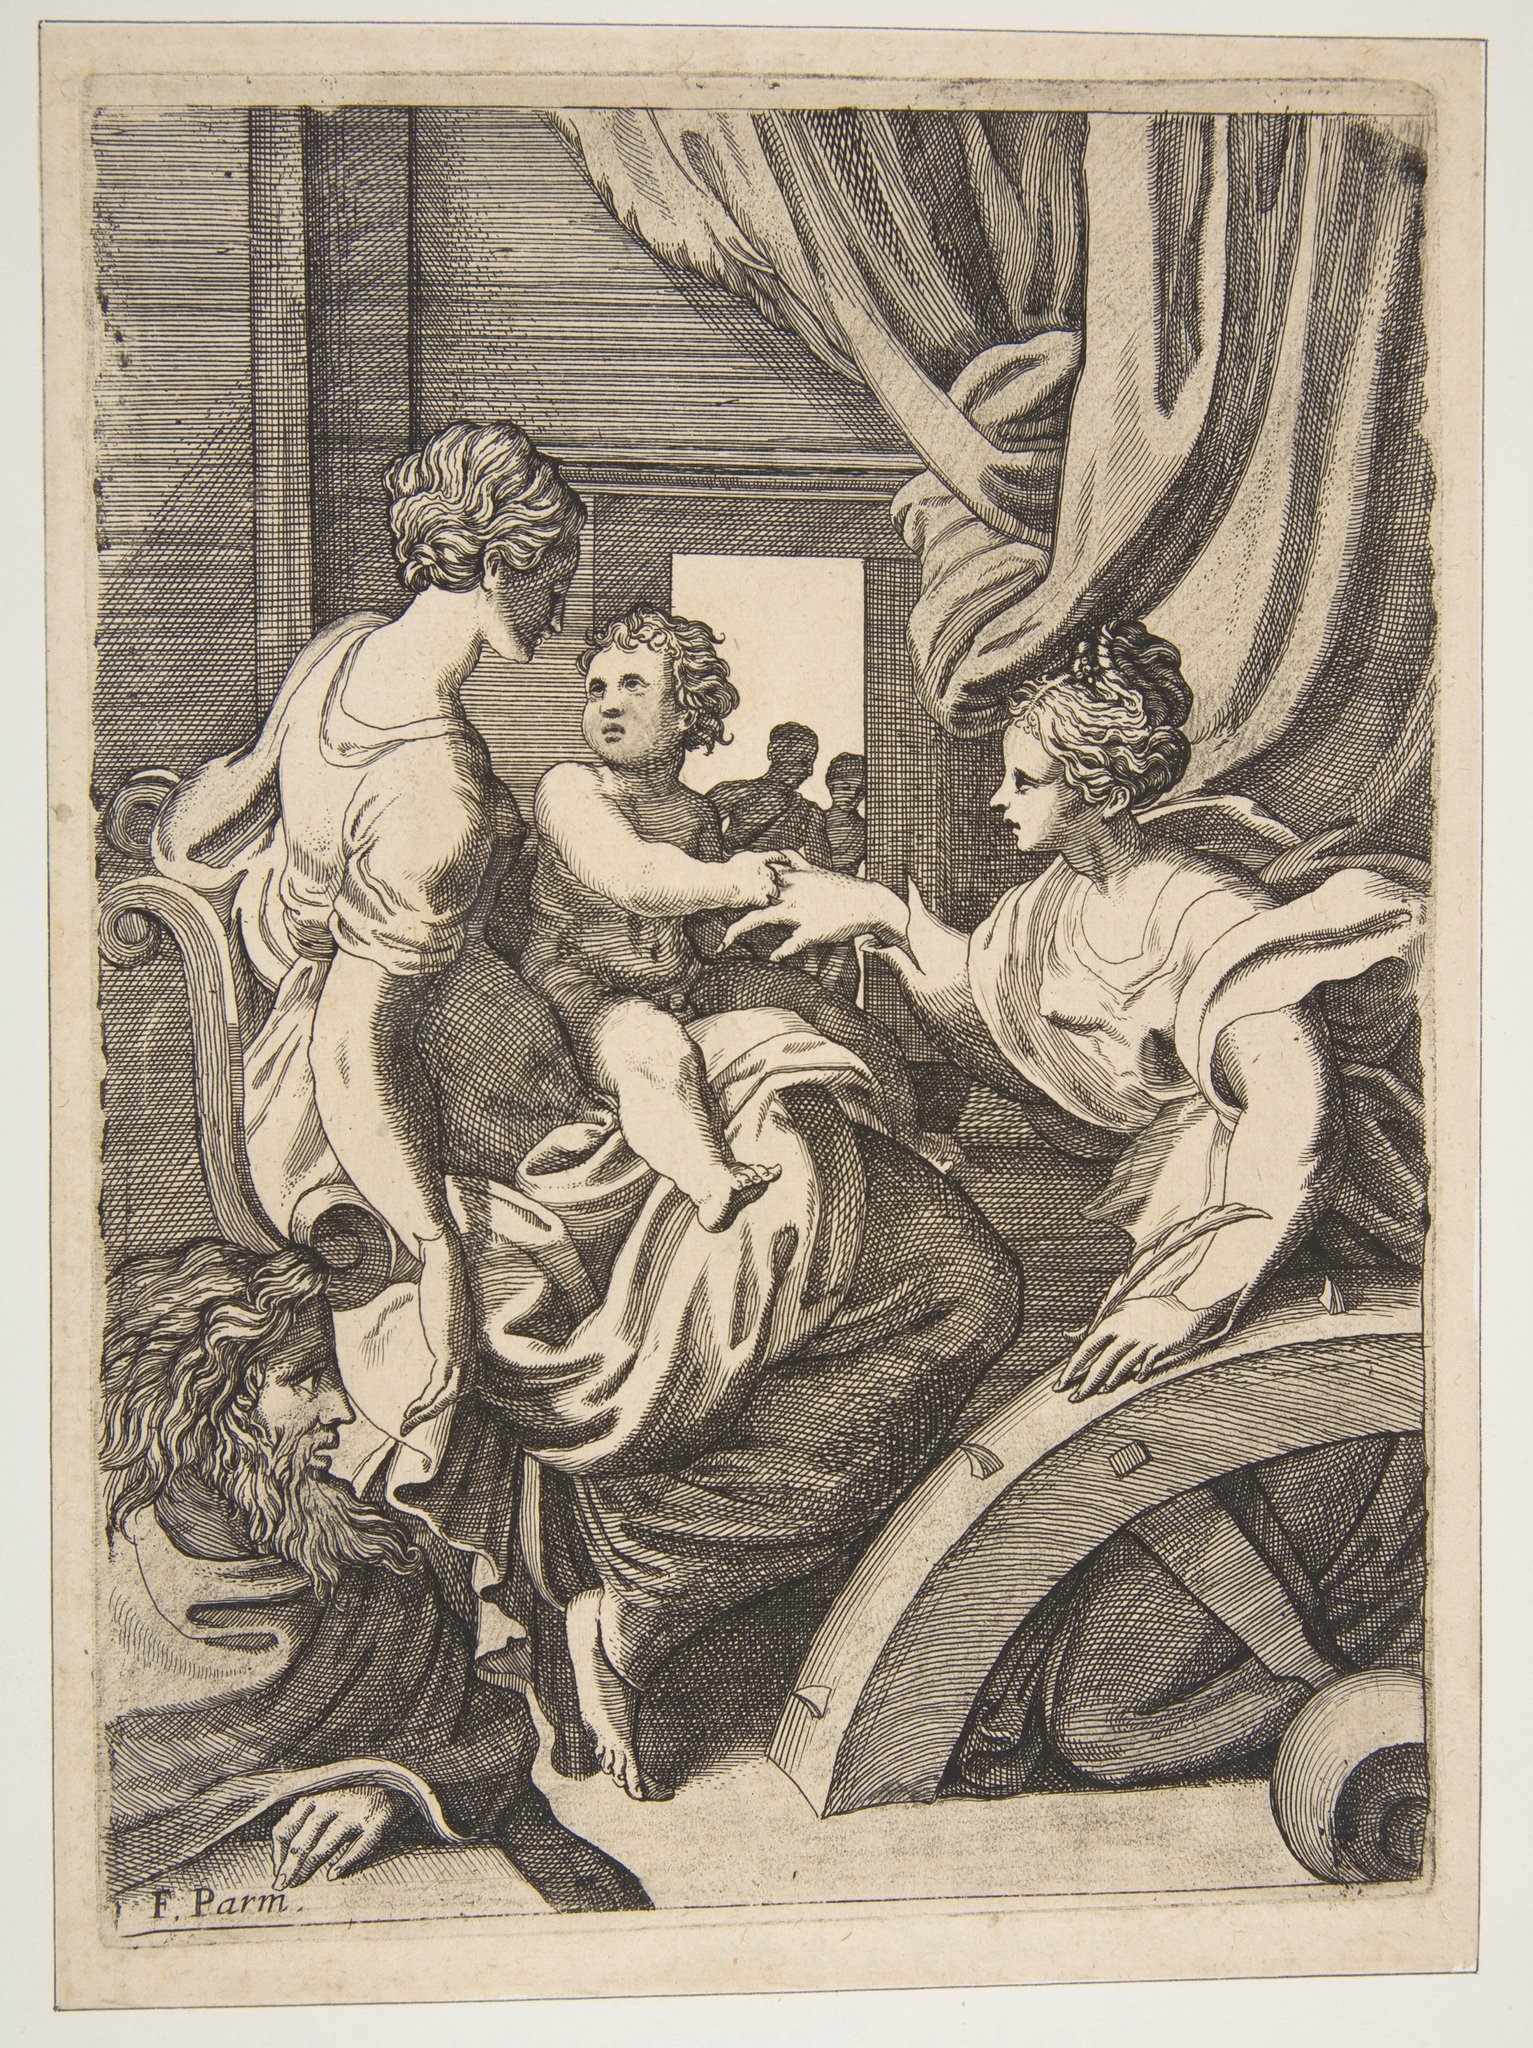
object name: print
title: The mystic marriage of Saint Catherine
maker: anonymous, italian, 16th century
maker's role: artist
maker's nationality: italian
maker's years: 1500-1600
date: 1560-1600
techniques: etching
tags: men,women,christ,saint catherine